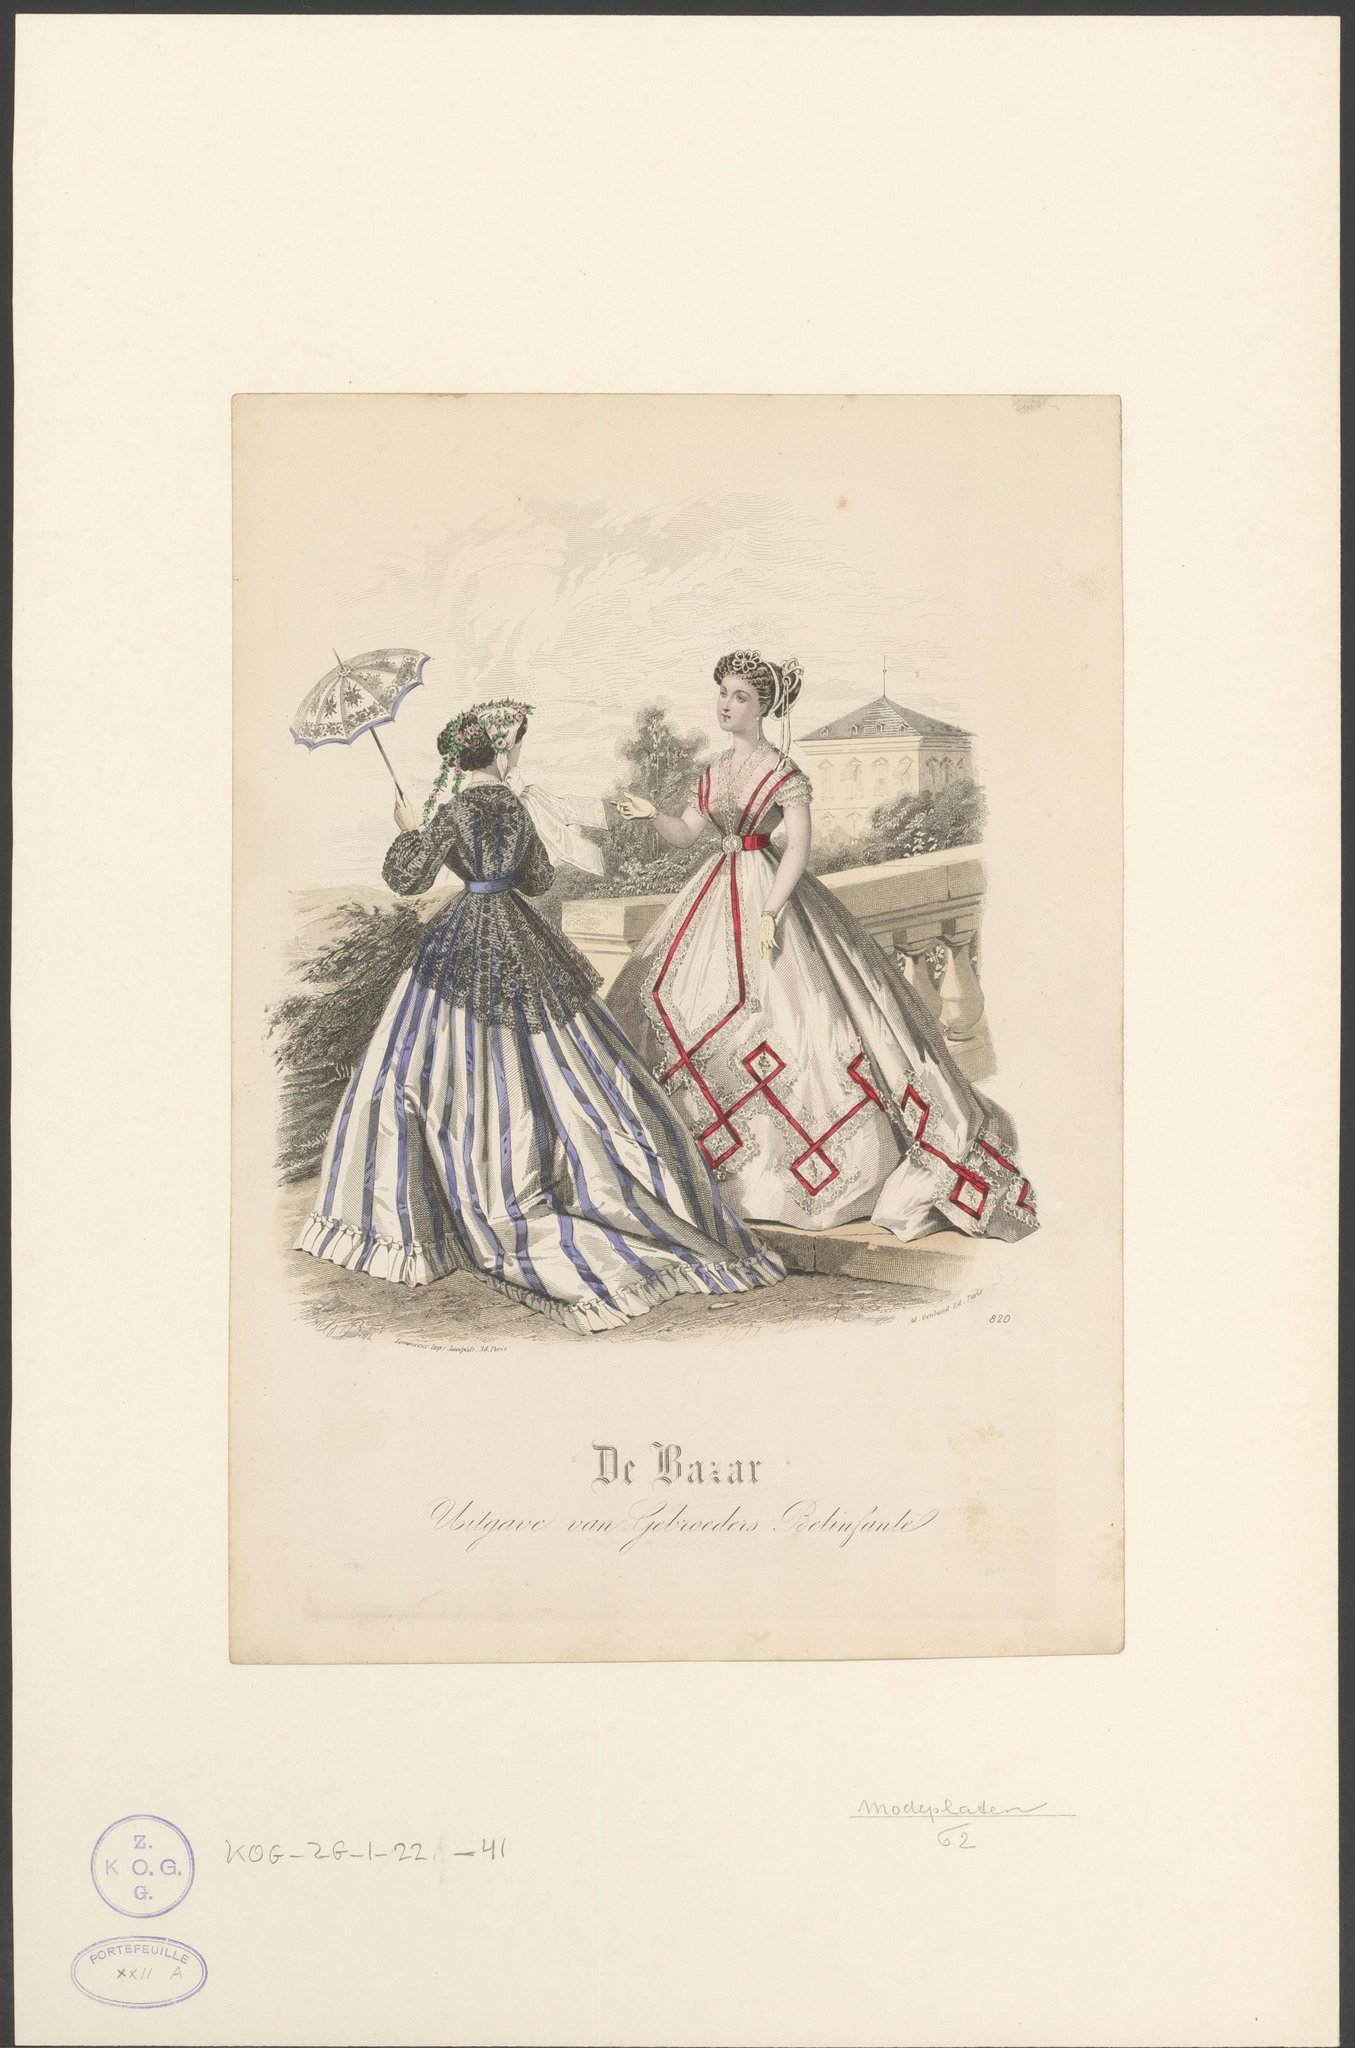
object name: print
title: De Bazar, Pl. 820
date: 1887-1890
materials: paper, watercolor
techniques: hand coloring, engraving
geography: paris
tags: fashion plates, clothes, costume (+ women's clothes), dress, gown (+ women's clothes)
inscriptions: collector's mark: Lugt 1641, collector's mark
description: Twee vrouwen op een veranda, de linker vrouw met parasol. Prent uit het modetijdschrift De Bazar, geïllustreerd Tijdschrift voor Modes en Handwerken (1857-1900). Onderwerpsrubrieken binnen de Atlas Zeden en Gewoonten: De Kleeding, Modeplaten.